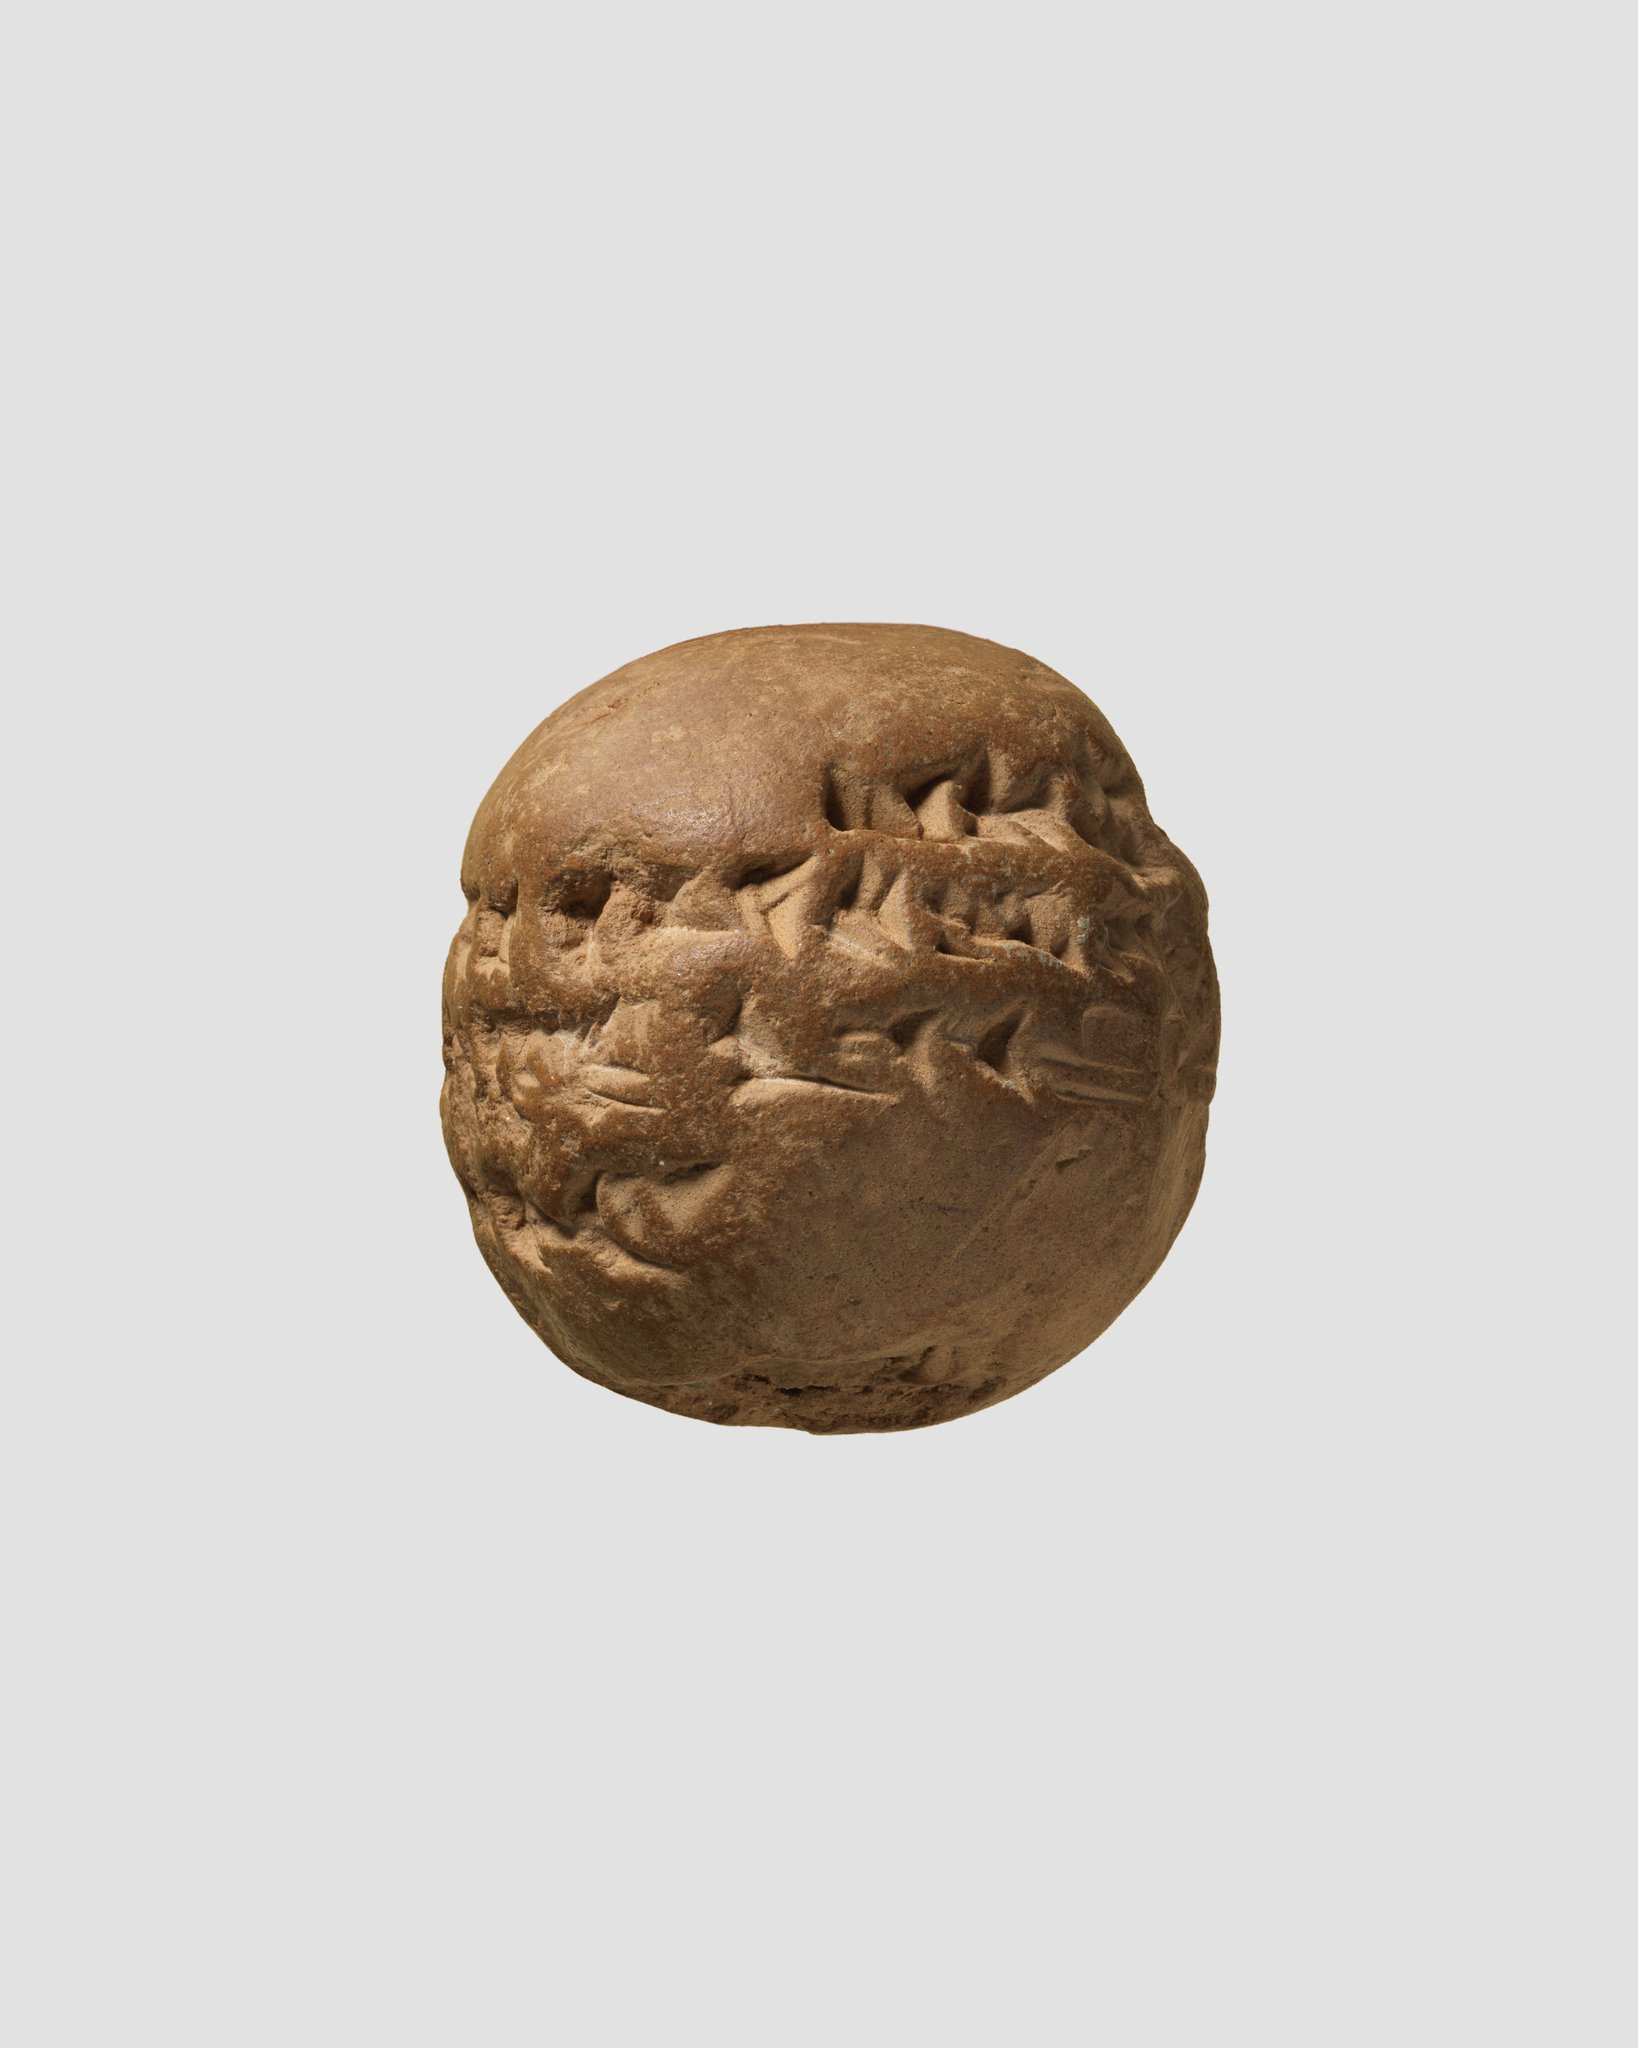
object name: clay ball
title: Inscribed clay ball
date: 333-1 BCE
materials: clay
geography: mesopotamia